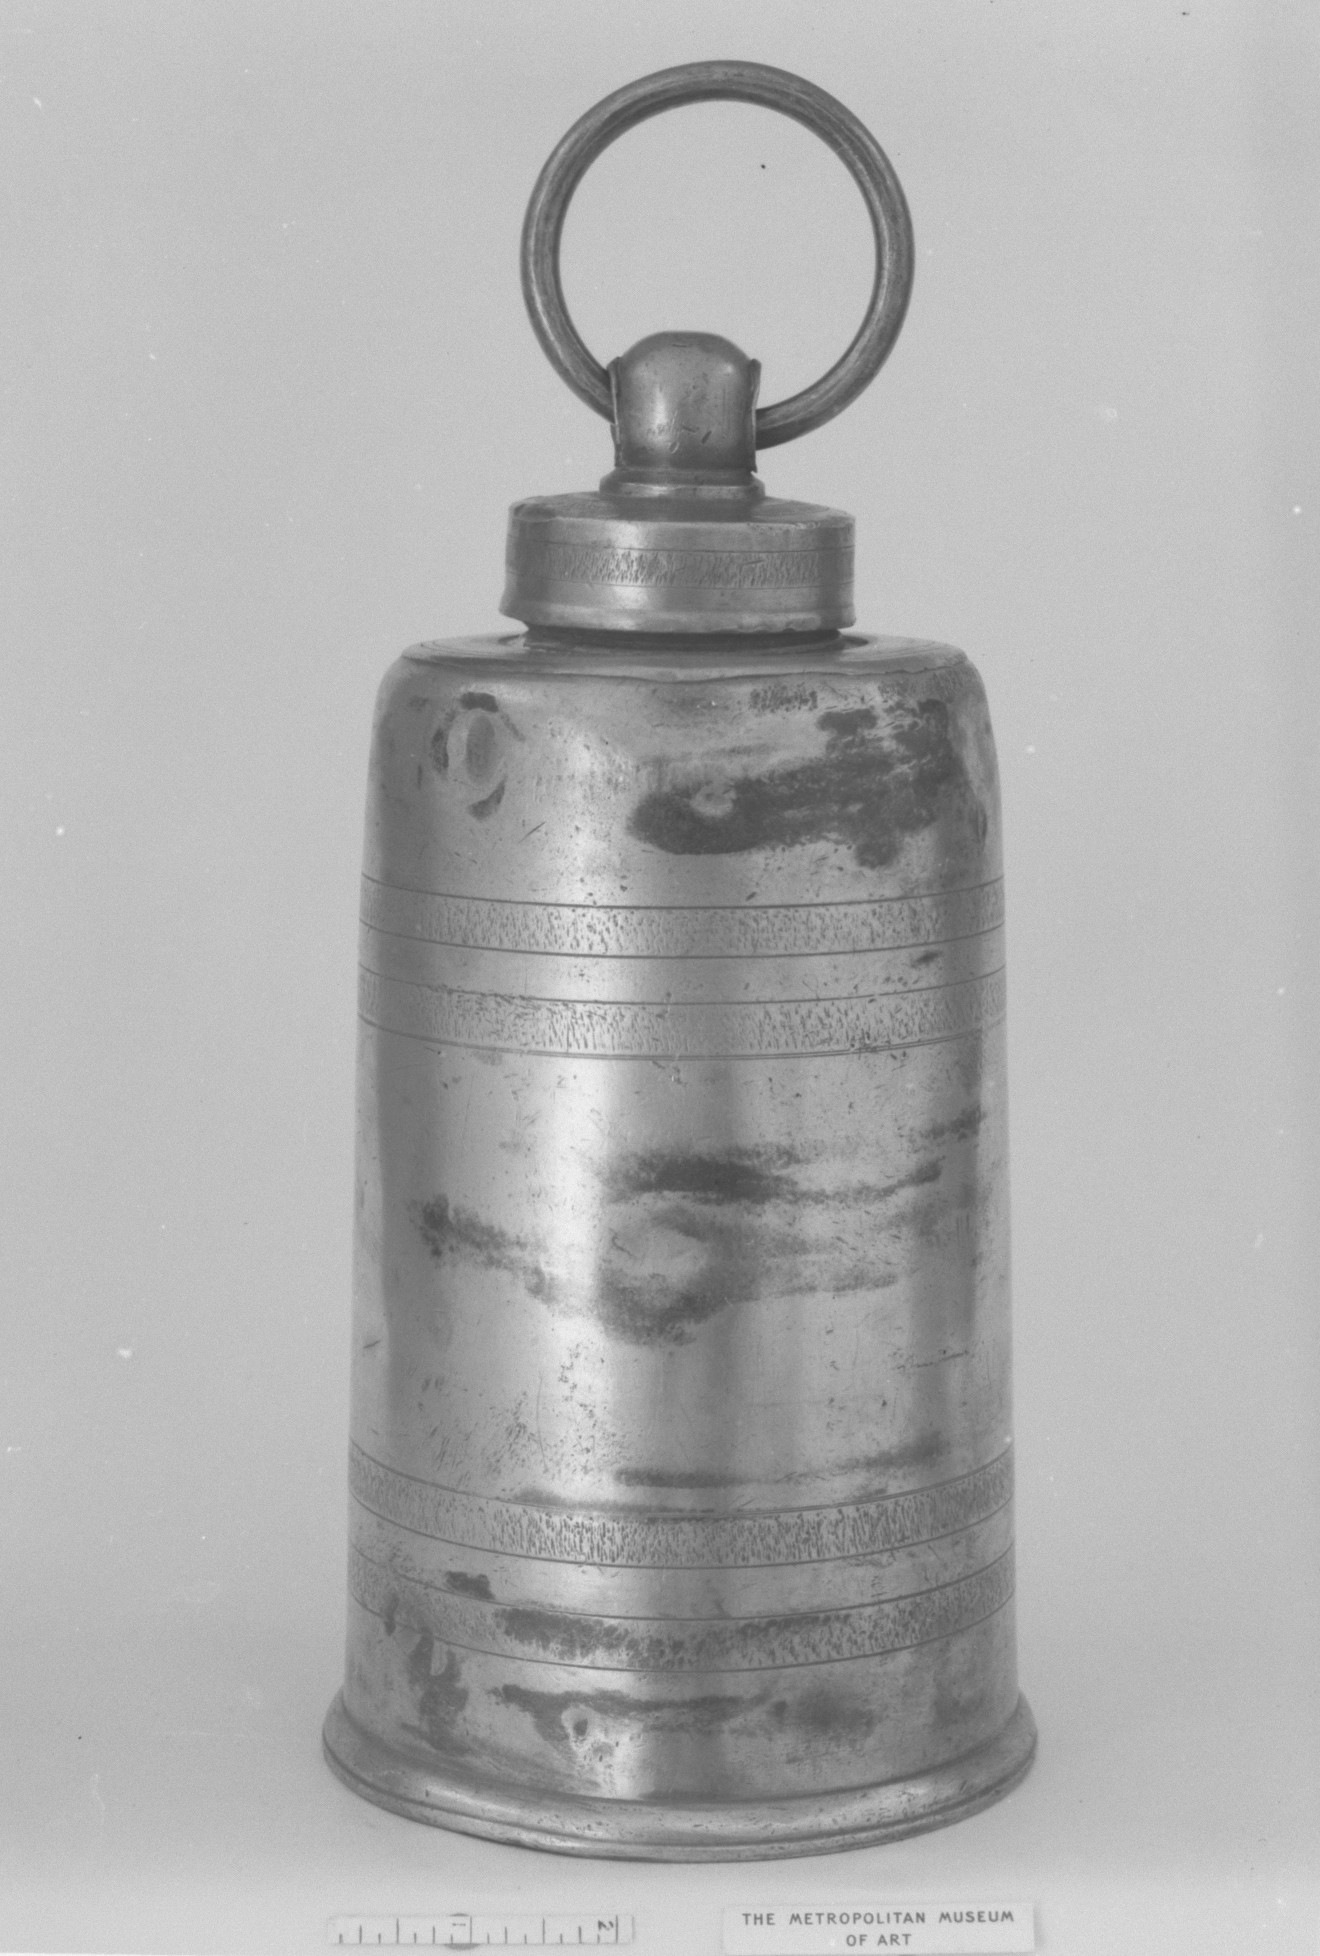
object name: food bottle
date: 1701-1800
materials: pewter